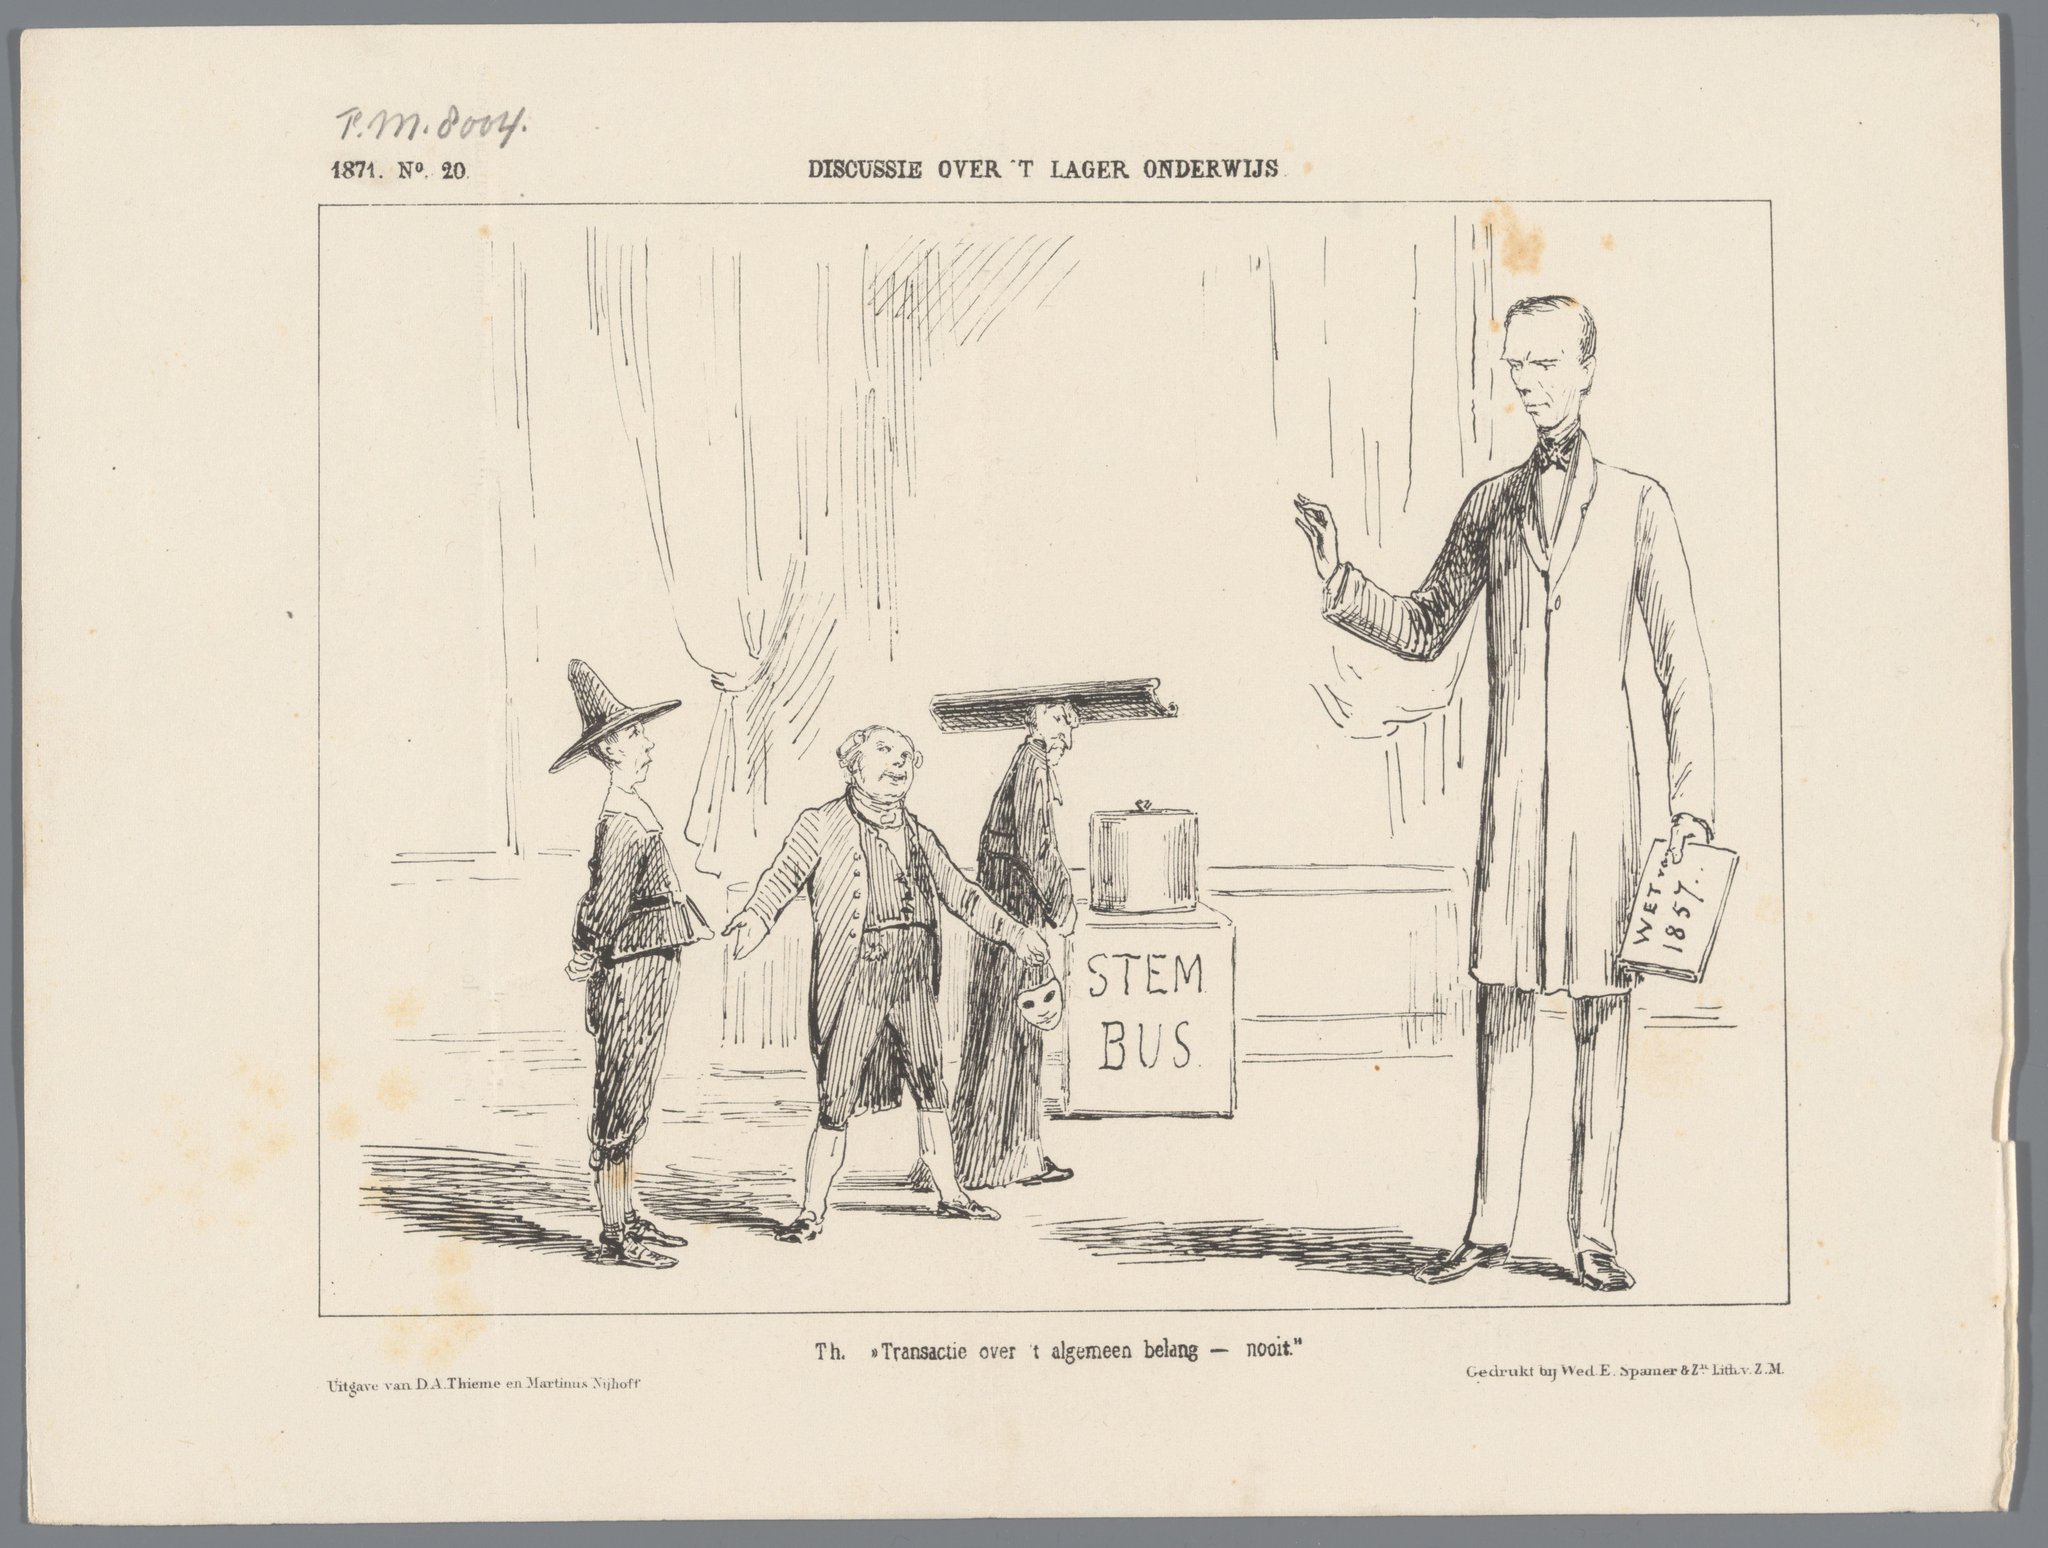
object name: cartoon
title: Discussie over 't lager onderwijs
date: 1871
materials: paper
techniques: lithograph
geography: netherlands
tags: johan rudolf thorbecke, elementary school; class, form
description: Spotprent waarin Minister van Binnenlandse Zaken Thorbecke het verzoek van de oppostie afwijst over een stembusgang over het lager onderwijs. Plaat verschenen bij het weekblad De Nederlandsche Spectator, nr. 20, 1871.